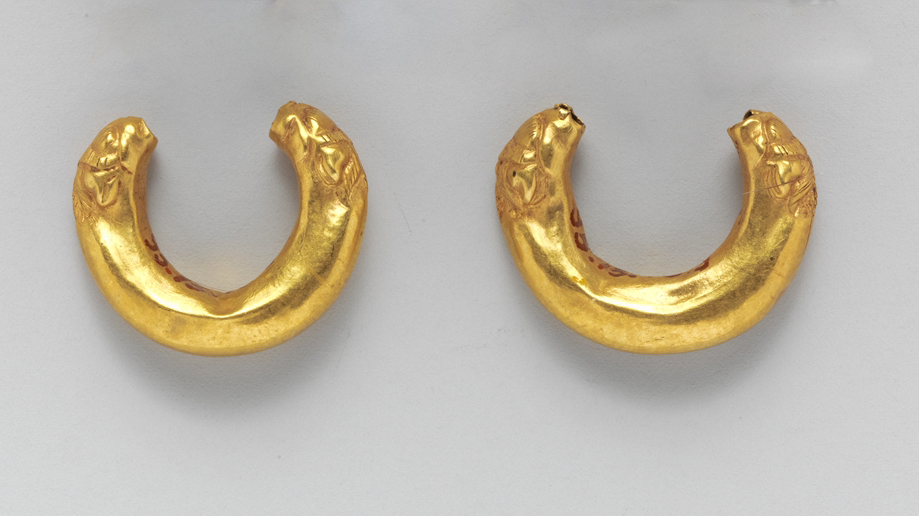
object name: earring, crescent shaped, with lions' head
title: Gold boat-shaped earrings with lions' heads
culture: etruscan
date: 400-201 BCE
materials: gold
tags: lions